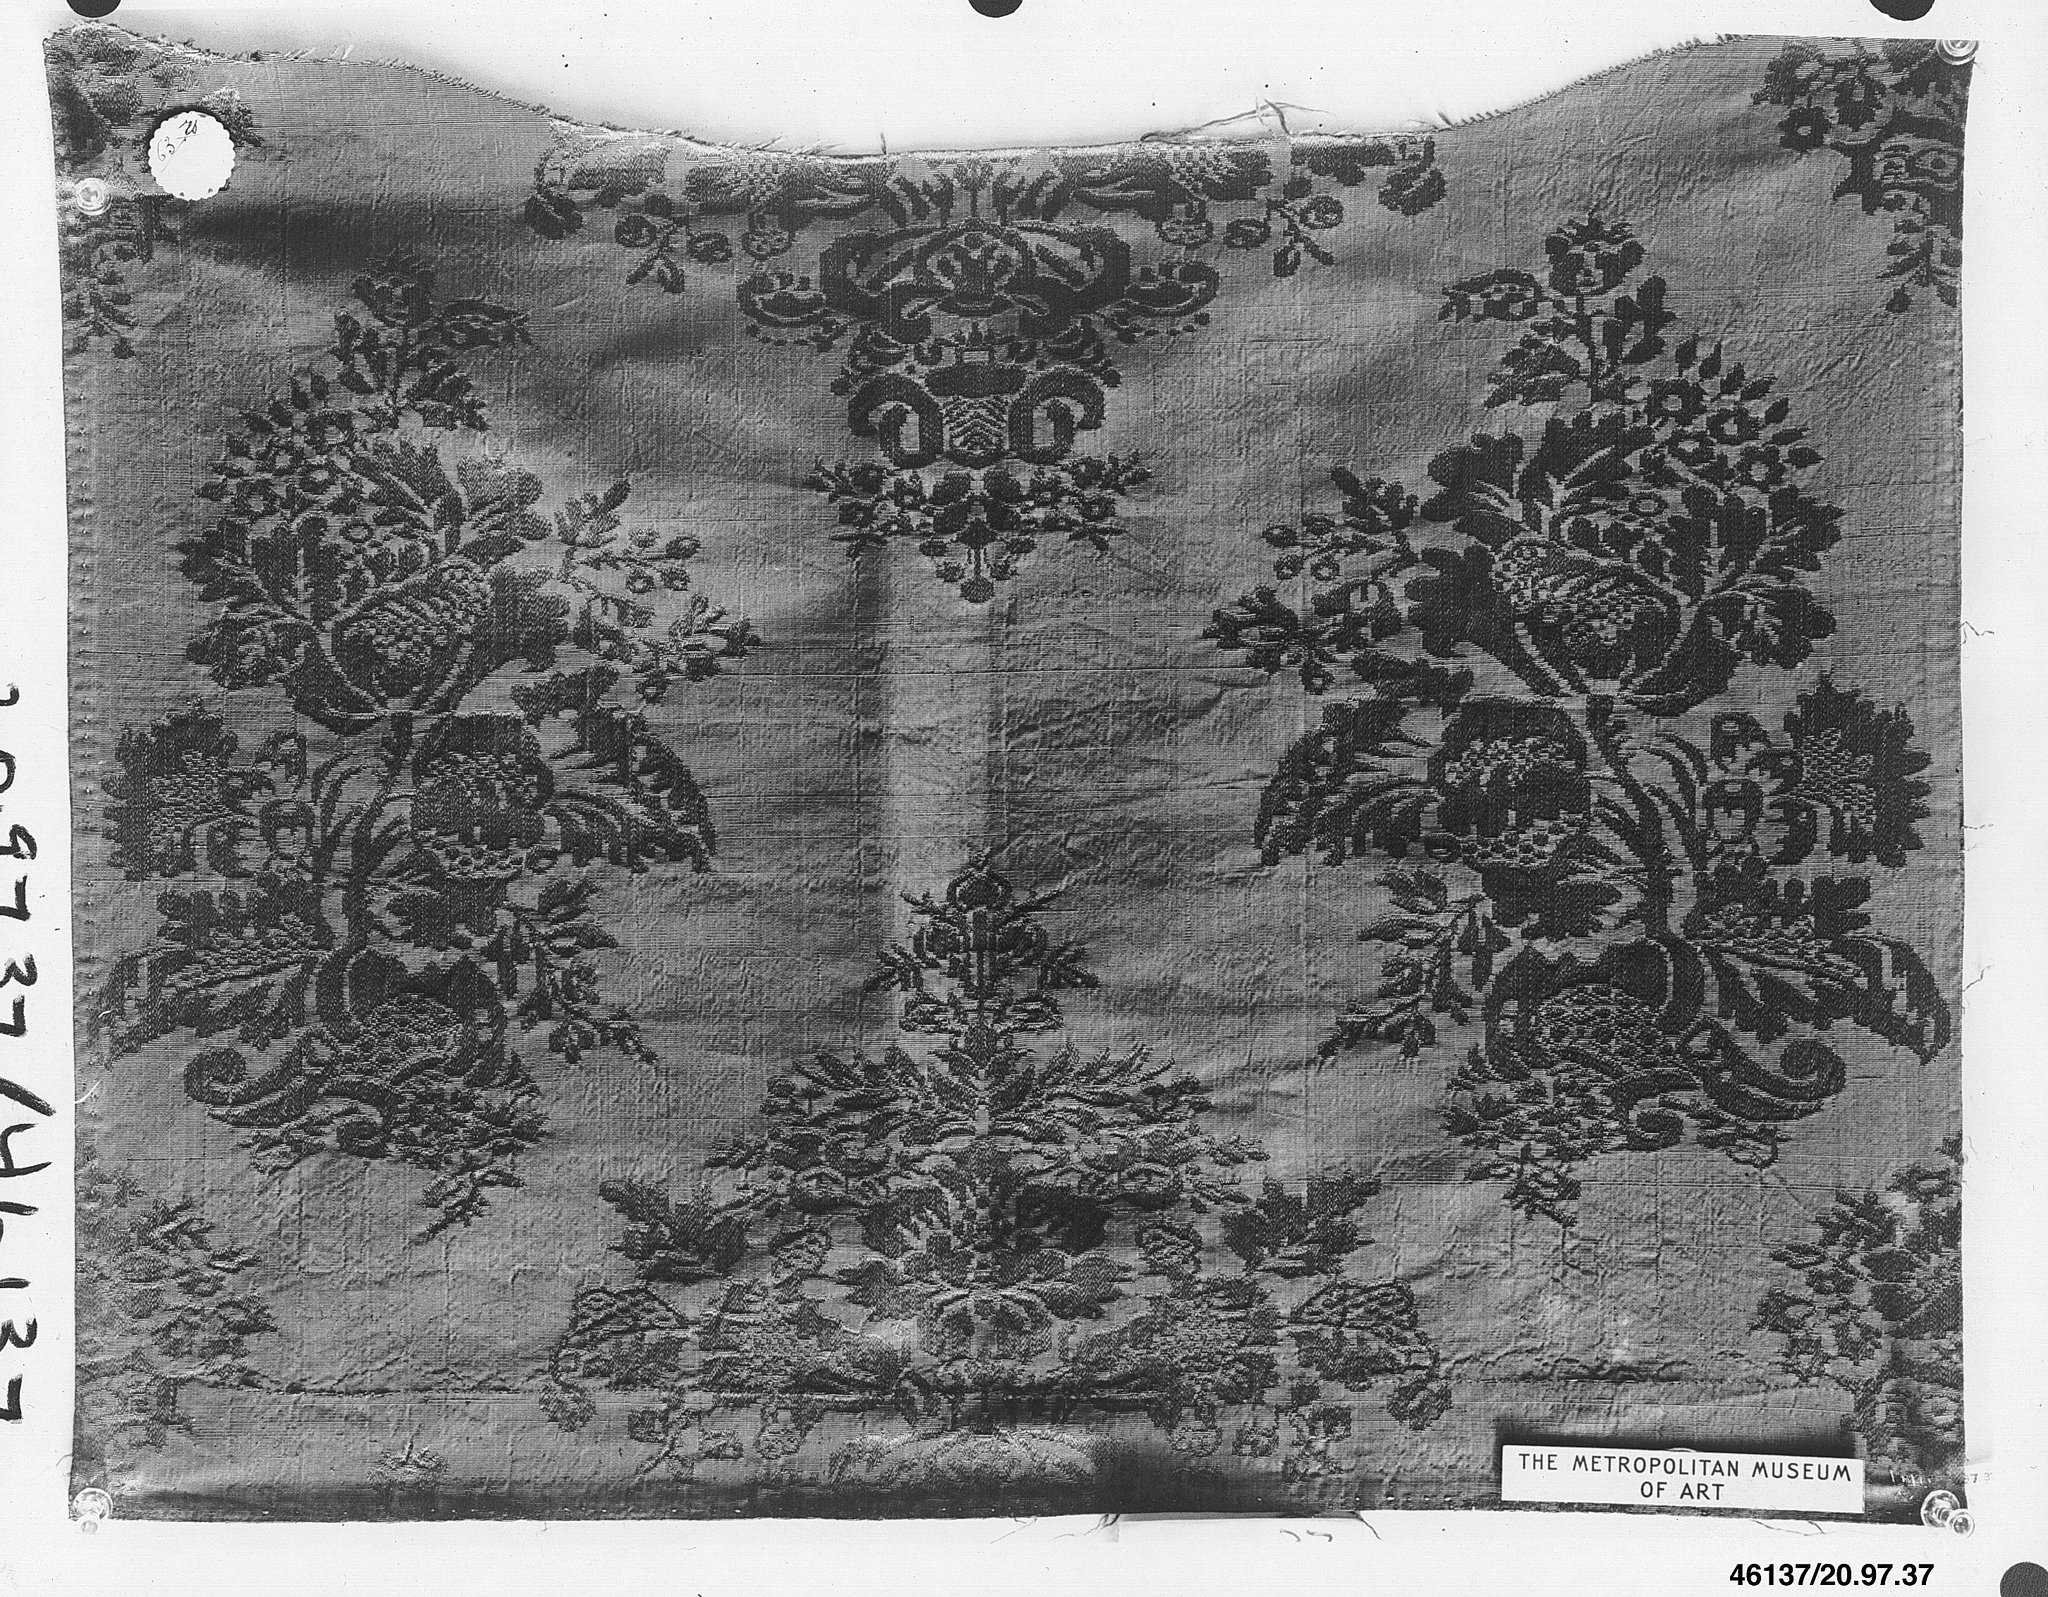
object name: piece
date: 1601-1700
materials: silk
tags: flowers,leaves